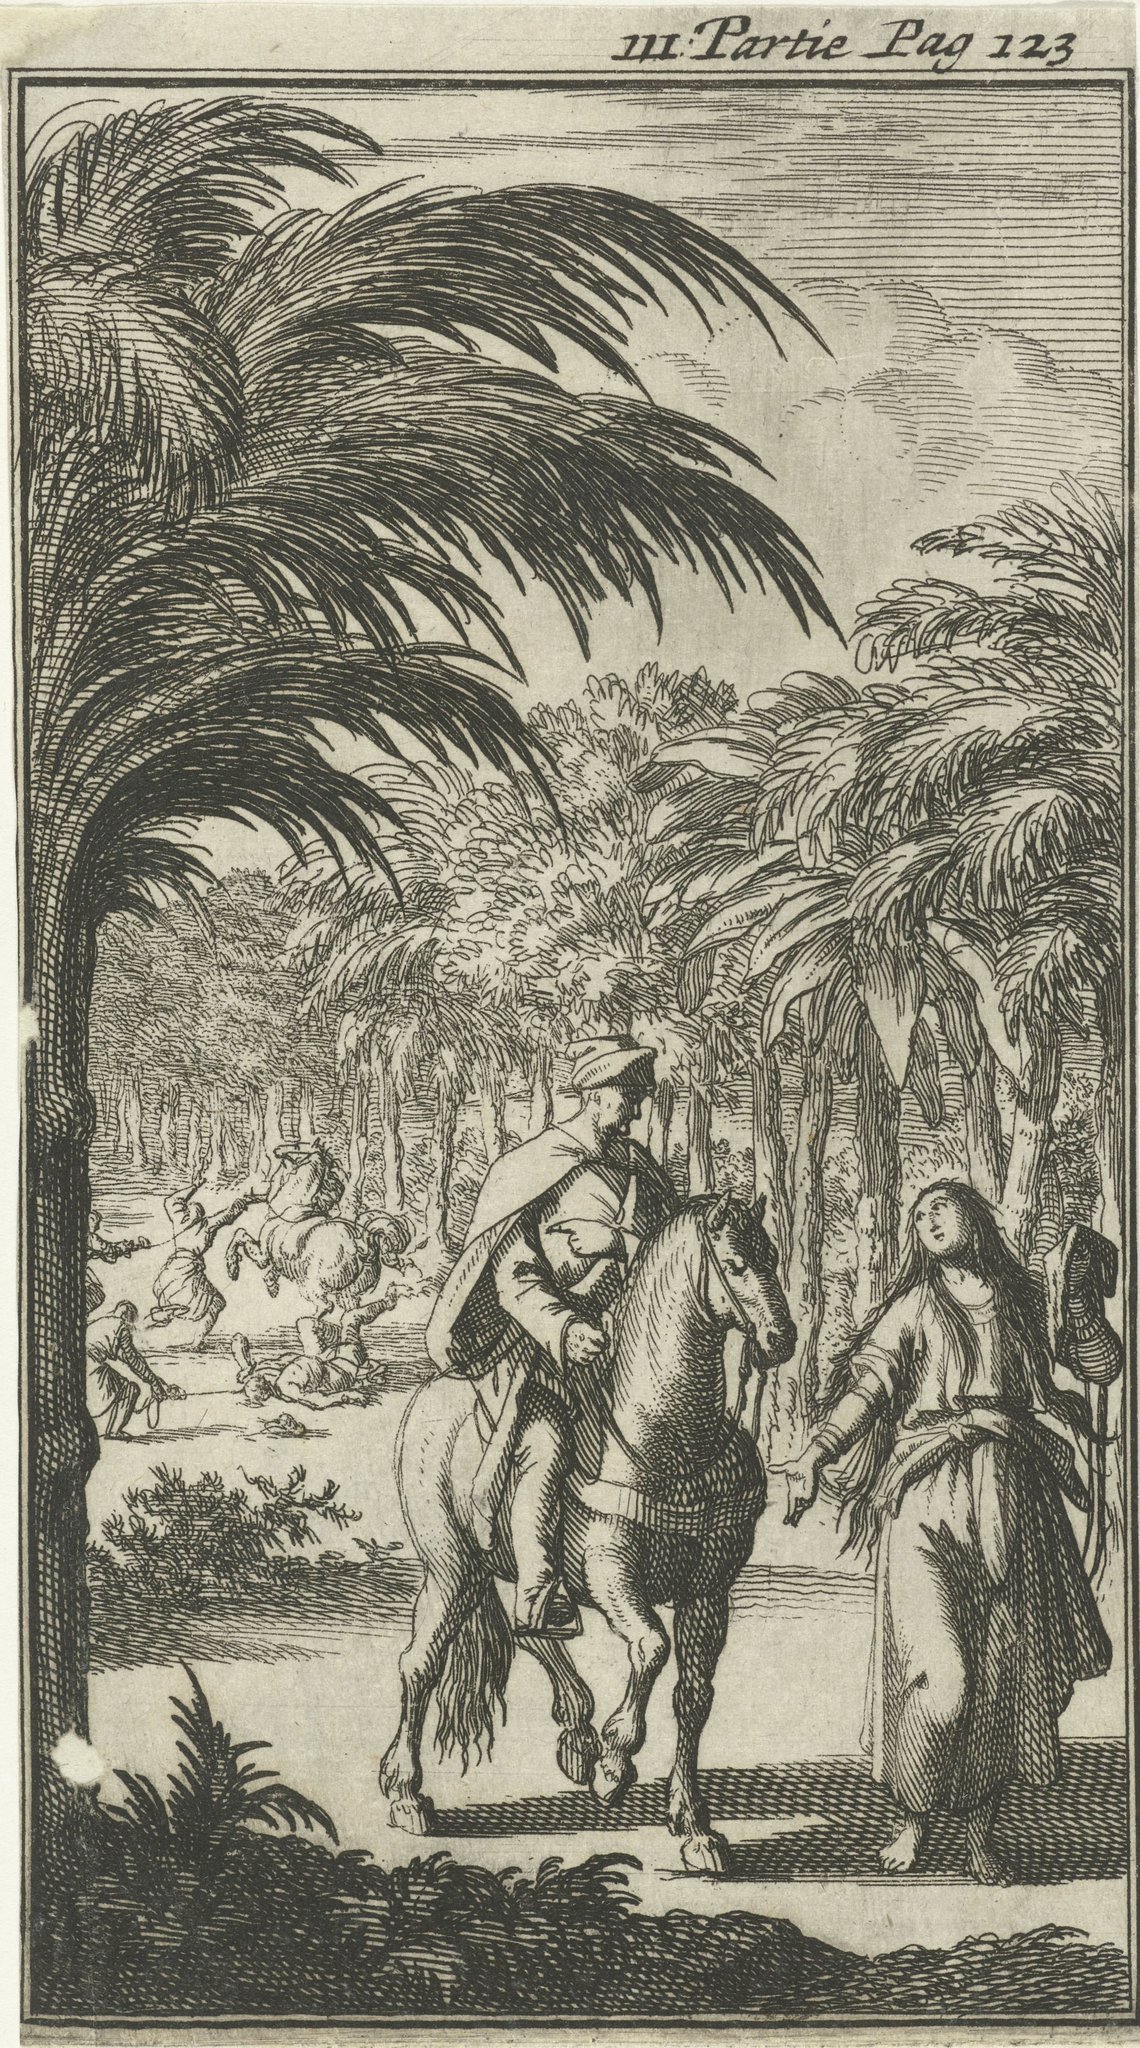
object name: print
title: Reiziger onderweg van Agra naar Dehli door een vrouwelijk lid van een roversbende aangesproken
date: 1689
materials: paper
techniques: etching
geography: paris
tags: riding a horse, ass, or mule; rider, horseman, traveller(s) attacked by robber(s), 'en route', traveller under way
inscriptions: collector's mark: Lugt 2228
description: Illustratie uit: Thevenot, Jean de. Voyages Tant en Europe qu'en Asie et en Afrique, 4 delen. Parijs: Charles Angot, 1689, dl. IV.